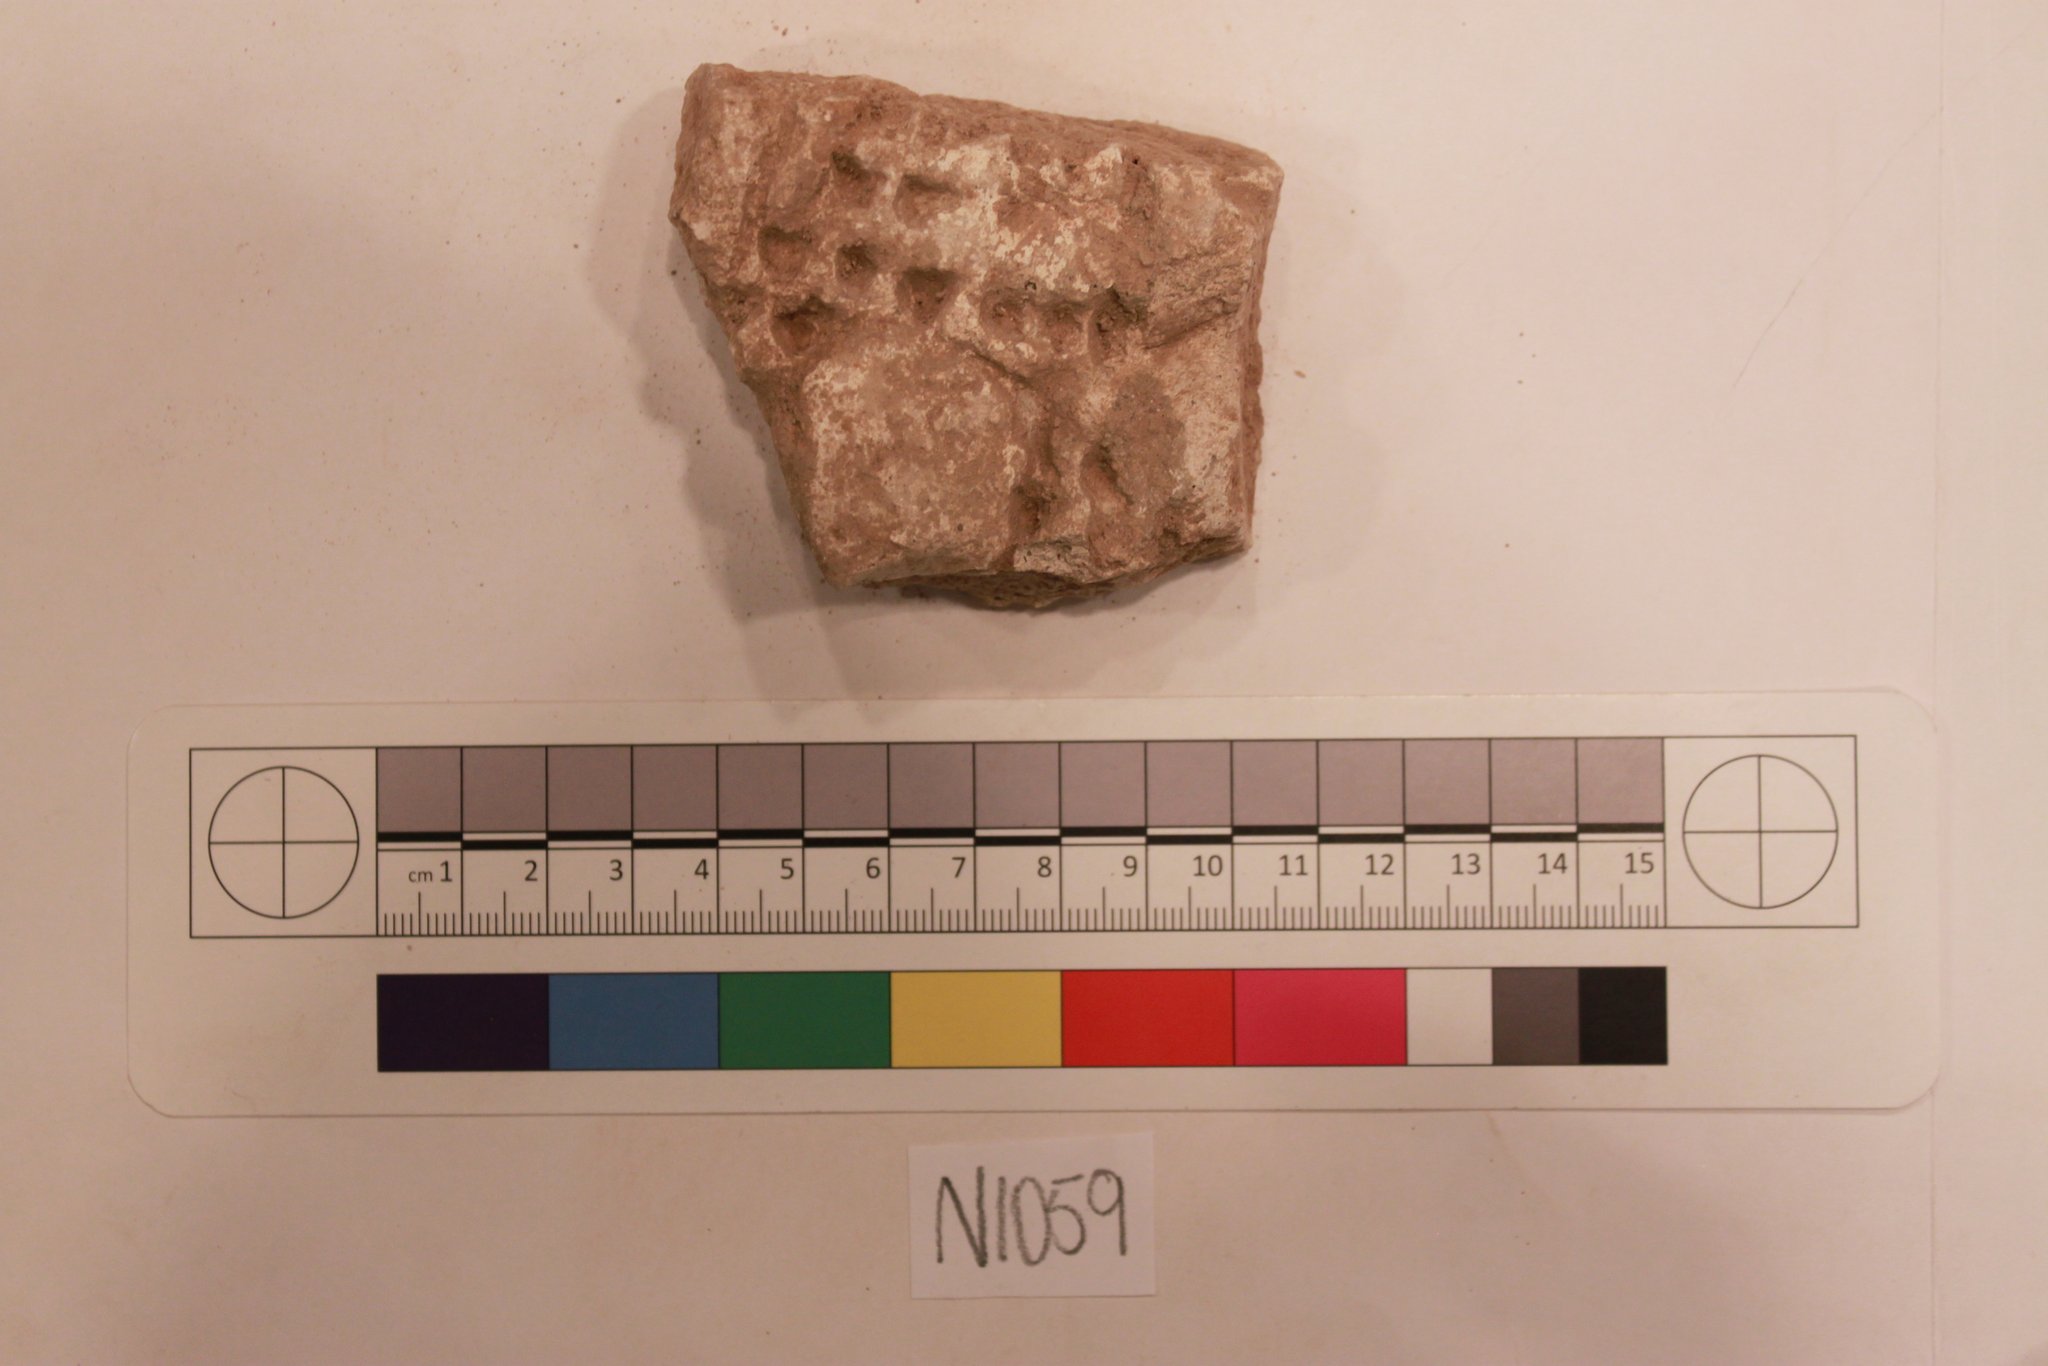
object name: fragment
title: Stucco Fragment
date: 701-1200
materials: plaster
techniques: carving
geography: iran